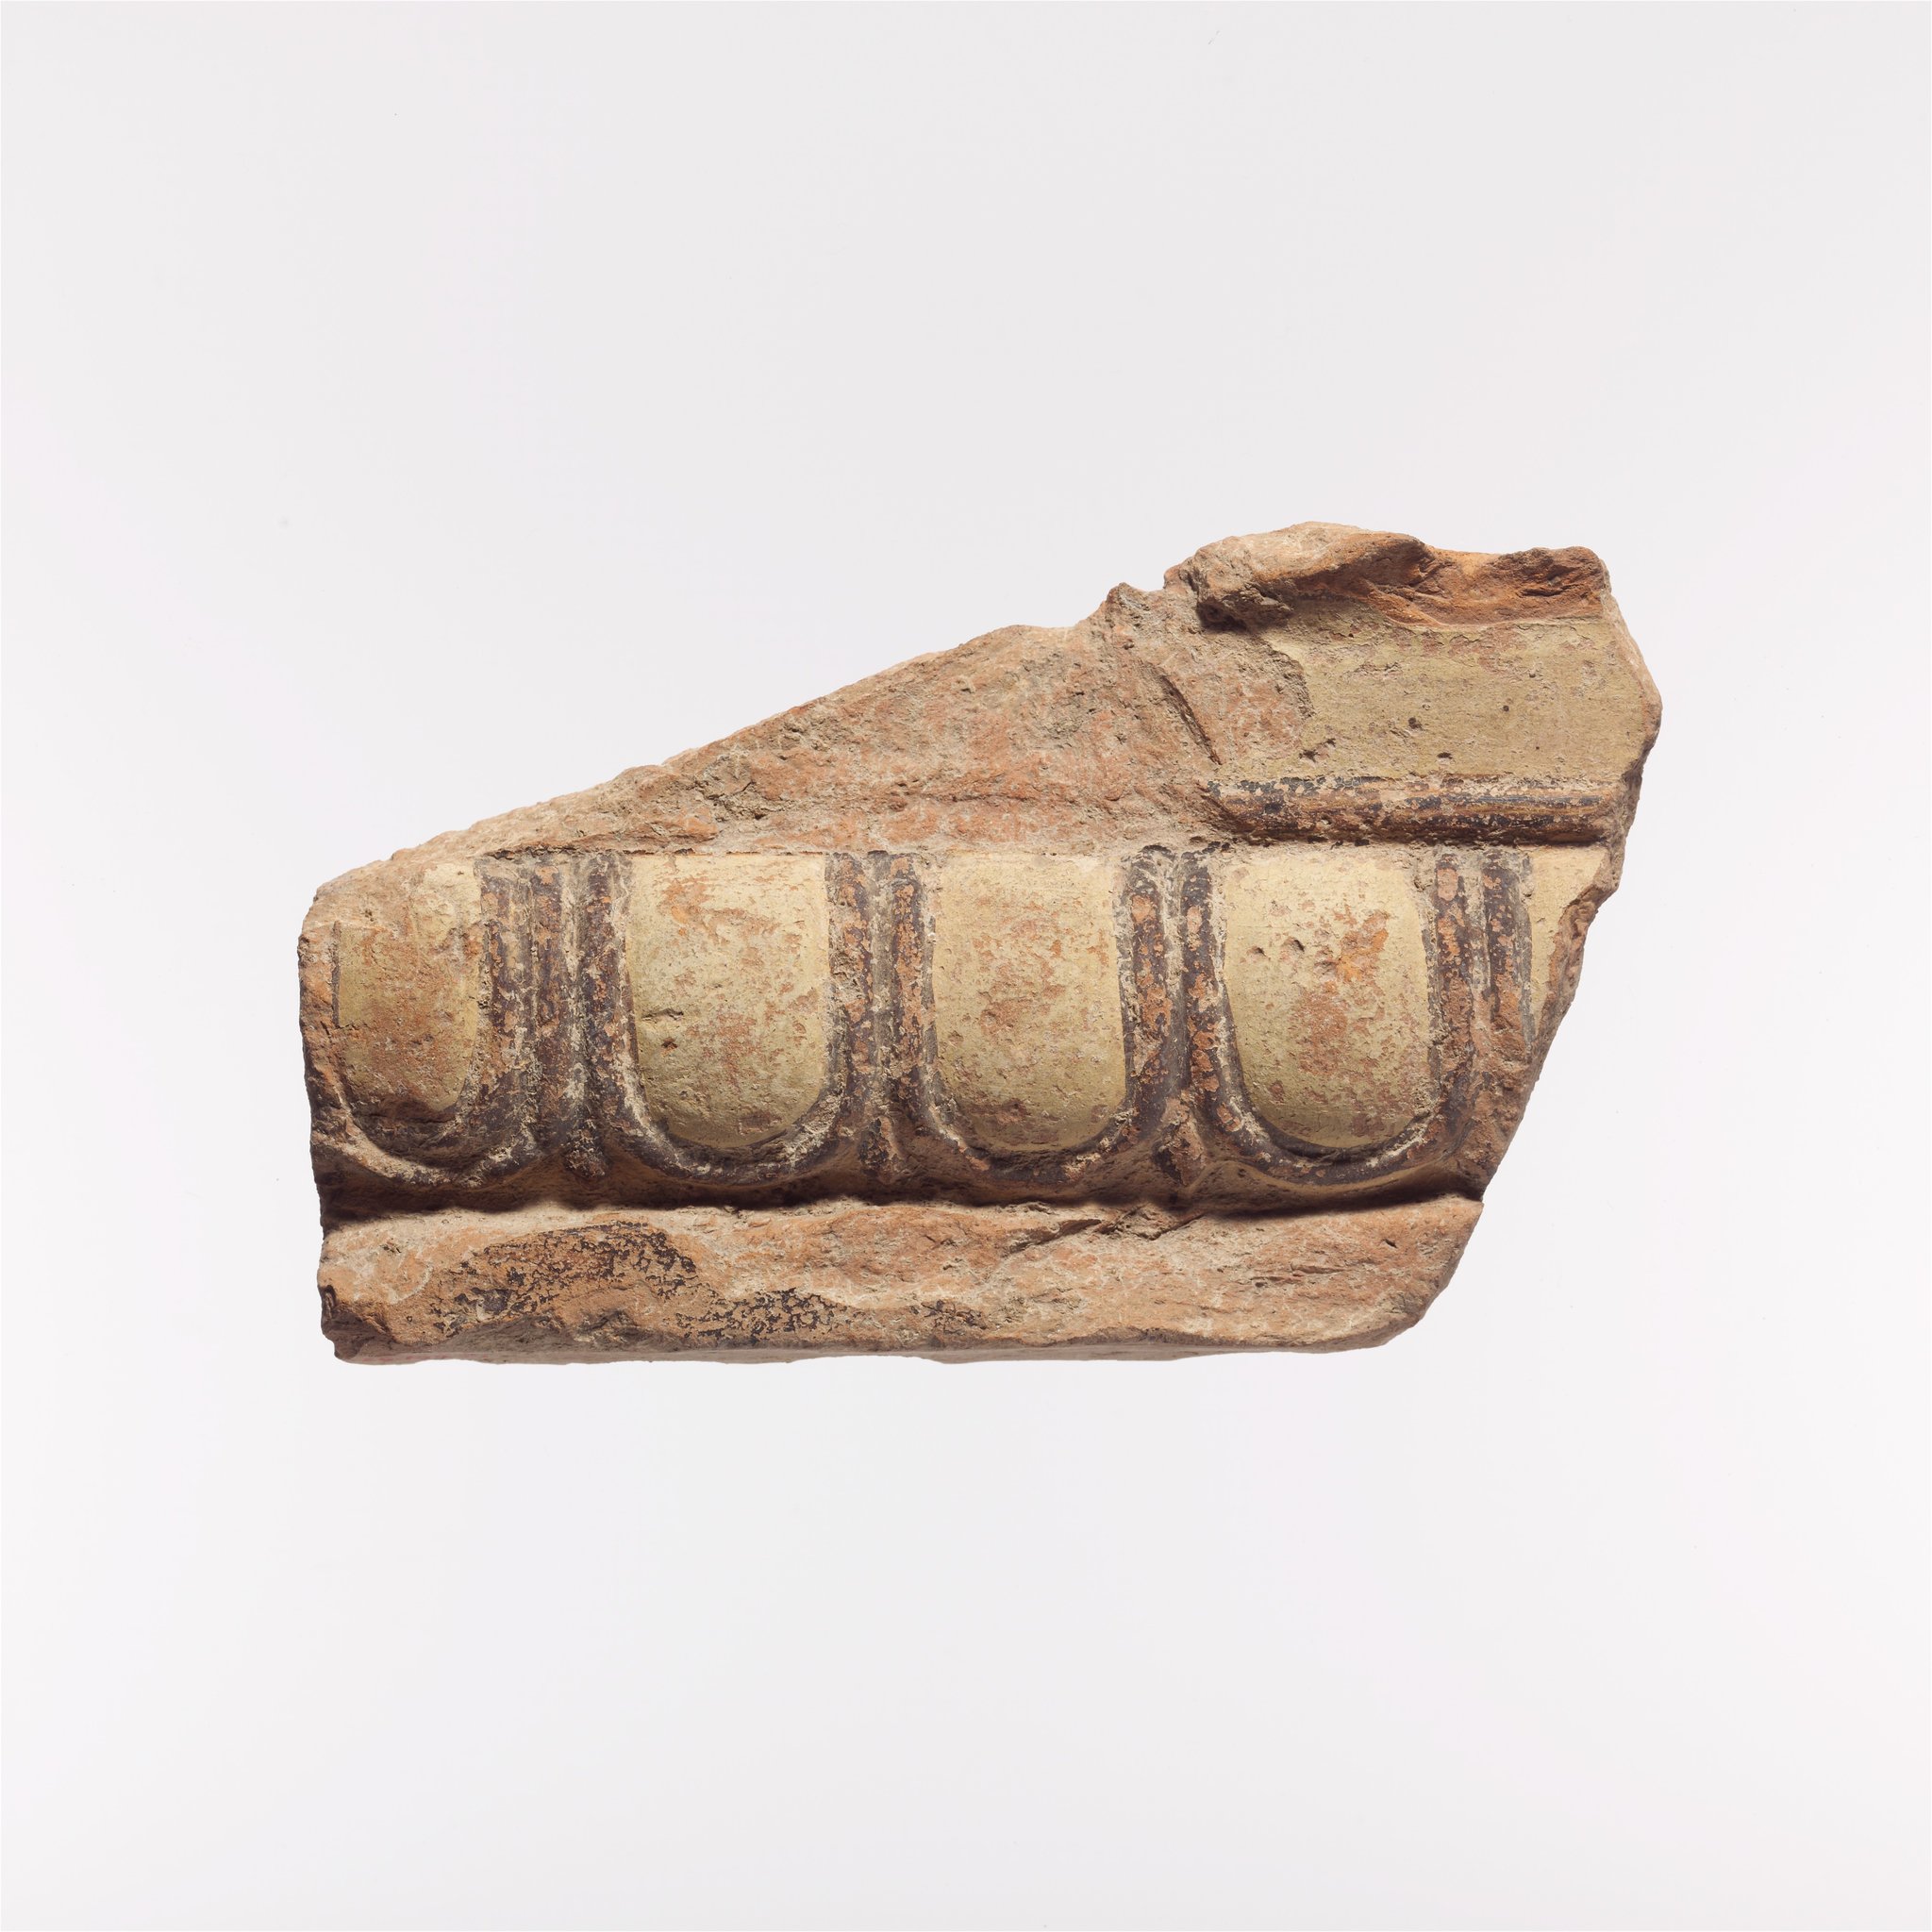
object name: tile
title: Fragment of a terracotta architectural tile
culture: lydian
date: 600-501 BCE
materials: terracotta